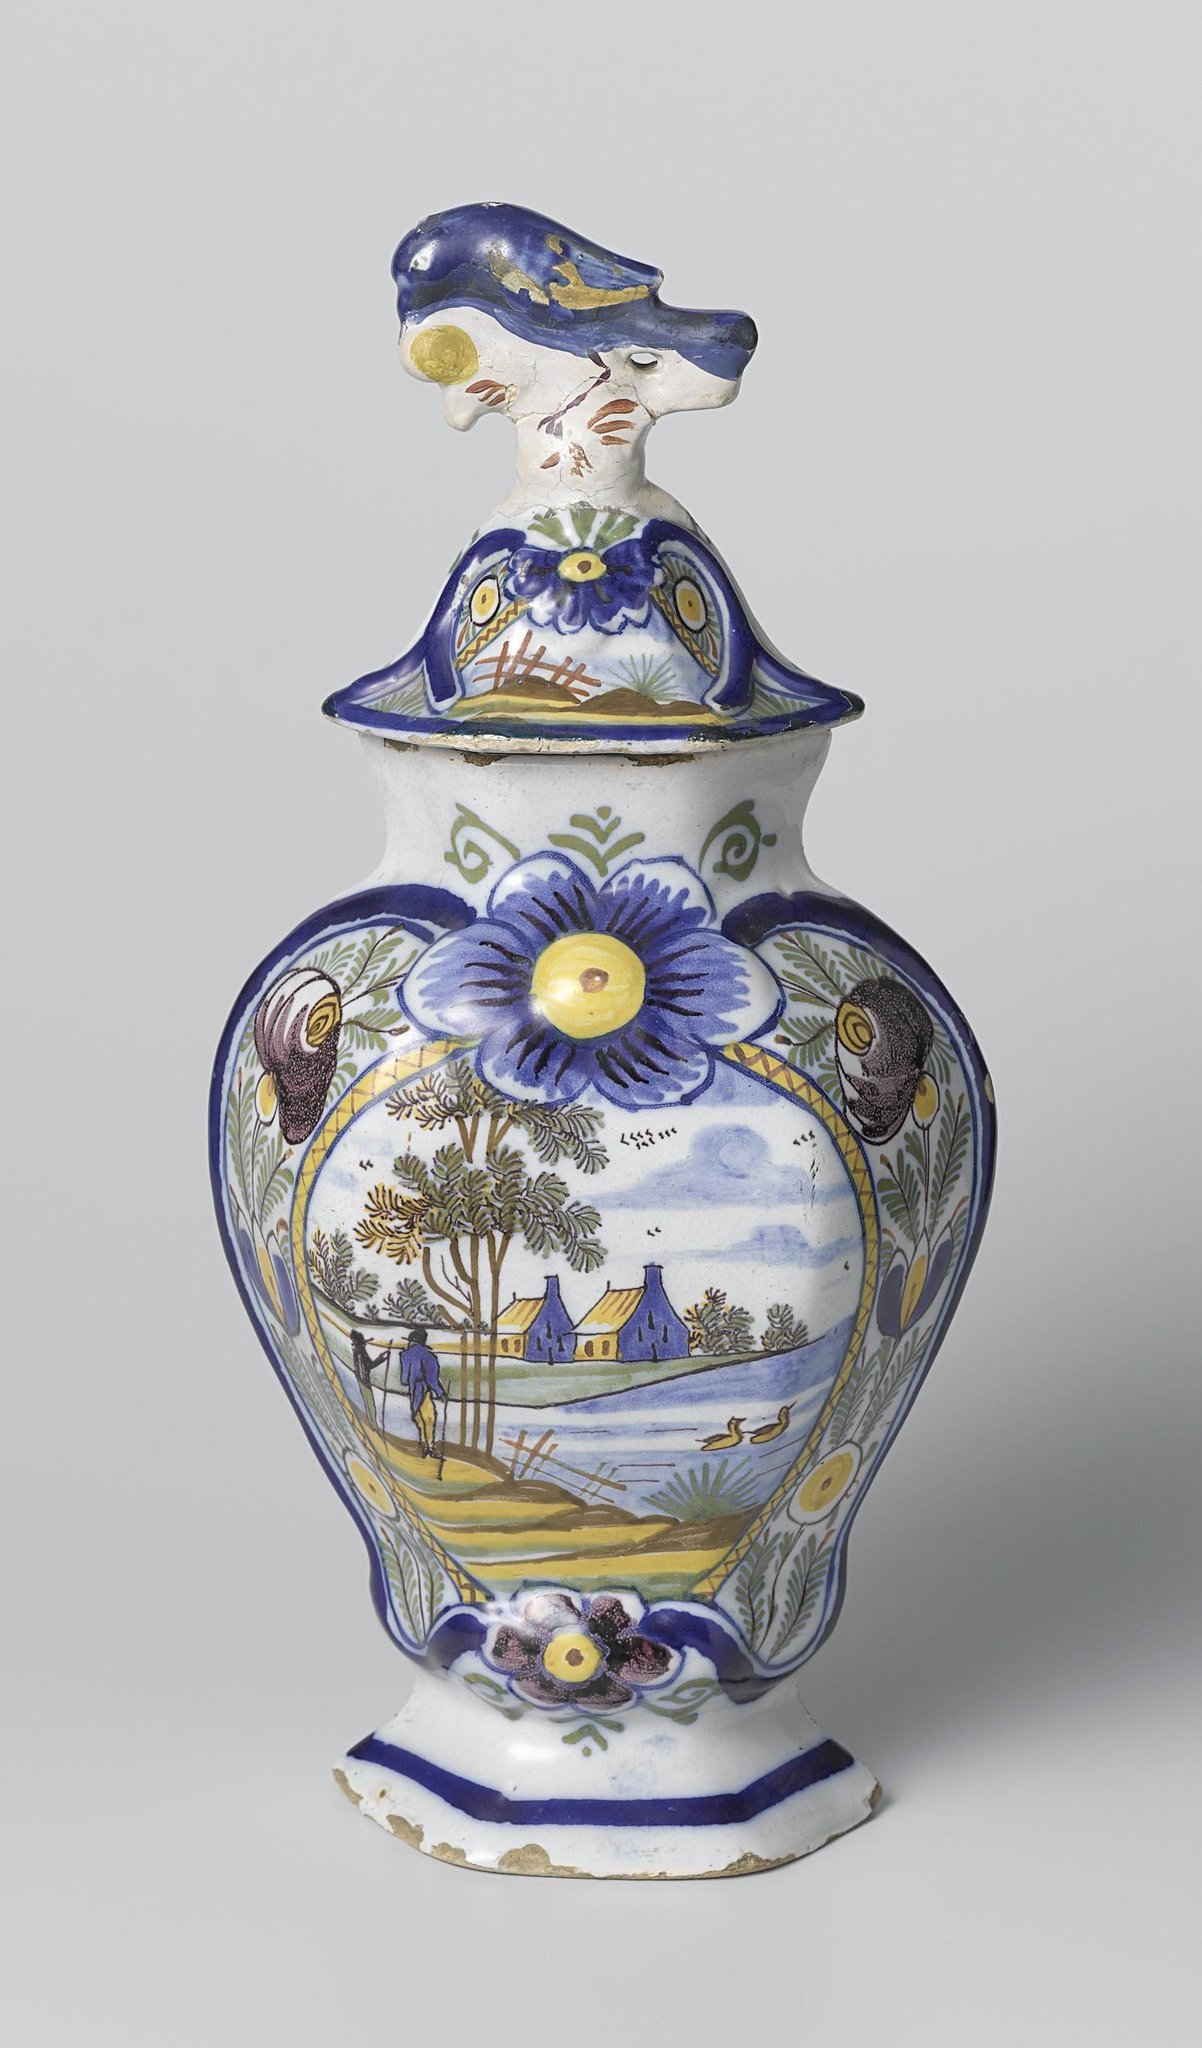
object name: covered jar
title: dekselpot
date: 1810-1840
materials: earthenware, glaze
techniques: painted, polychromy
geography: delft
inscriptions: mark: ‘B:P’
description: Pot van veelkleurig beschilderde faience. Op de pot is een cartouche met daarbinnen twee huizen in een landschap in de kleuren blauw, geel, groen, bruin en paars geschilderd. De knop van het deksel is een in een vrucht pikkende vogel. De pot hoort bij een identieke poten een beker.